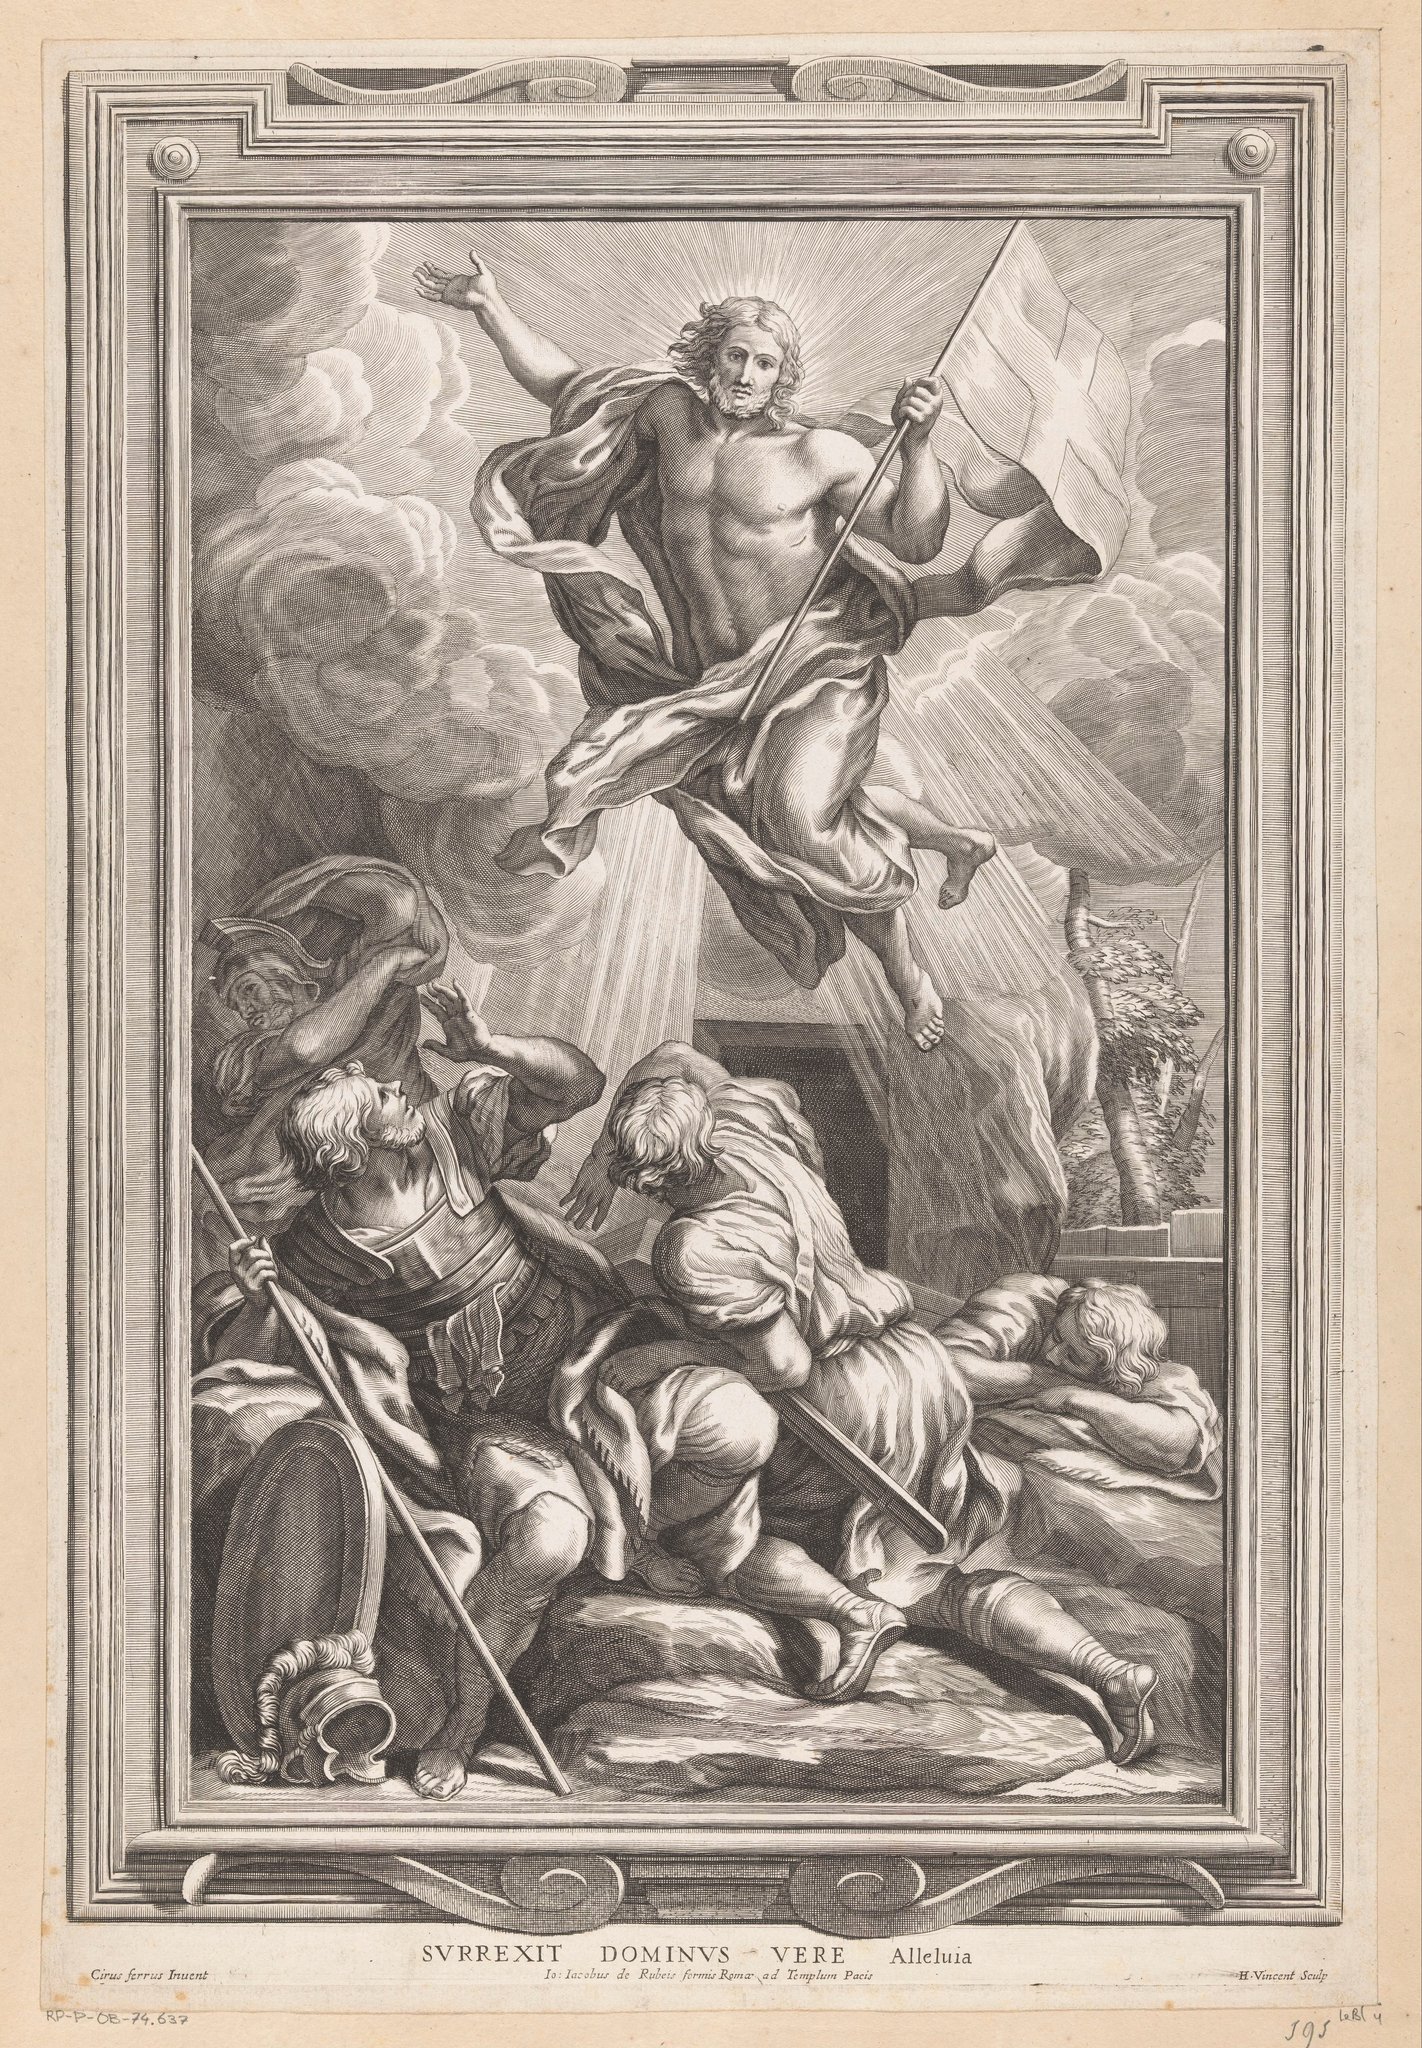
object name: print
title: Opstanding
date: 1680-1691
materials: paper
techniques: engraving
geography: rome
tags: resurrection of christ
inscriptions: collector's mark: Lugt 240